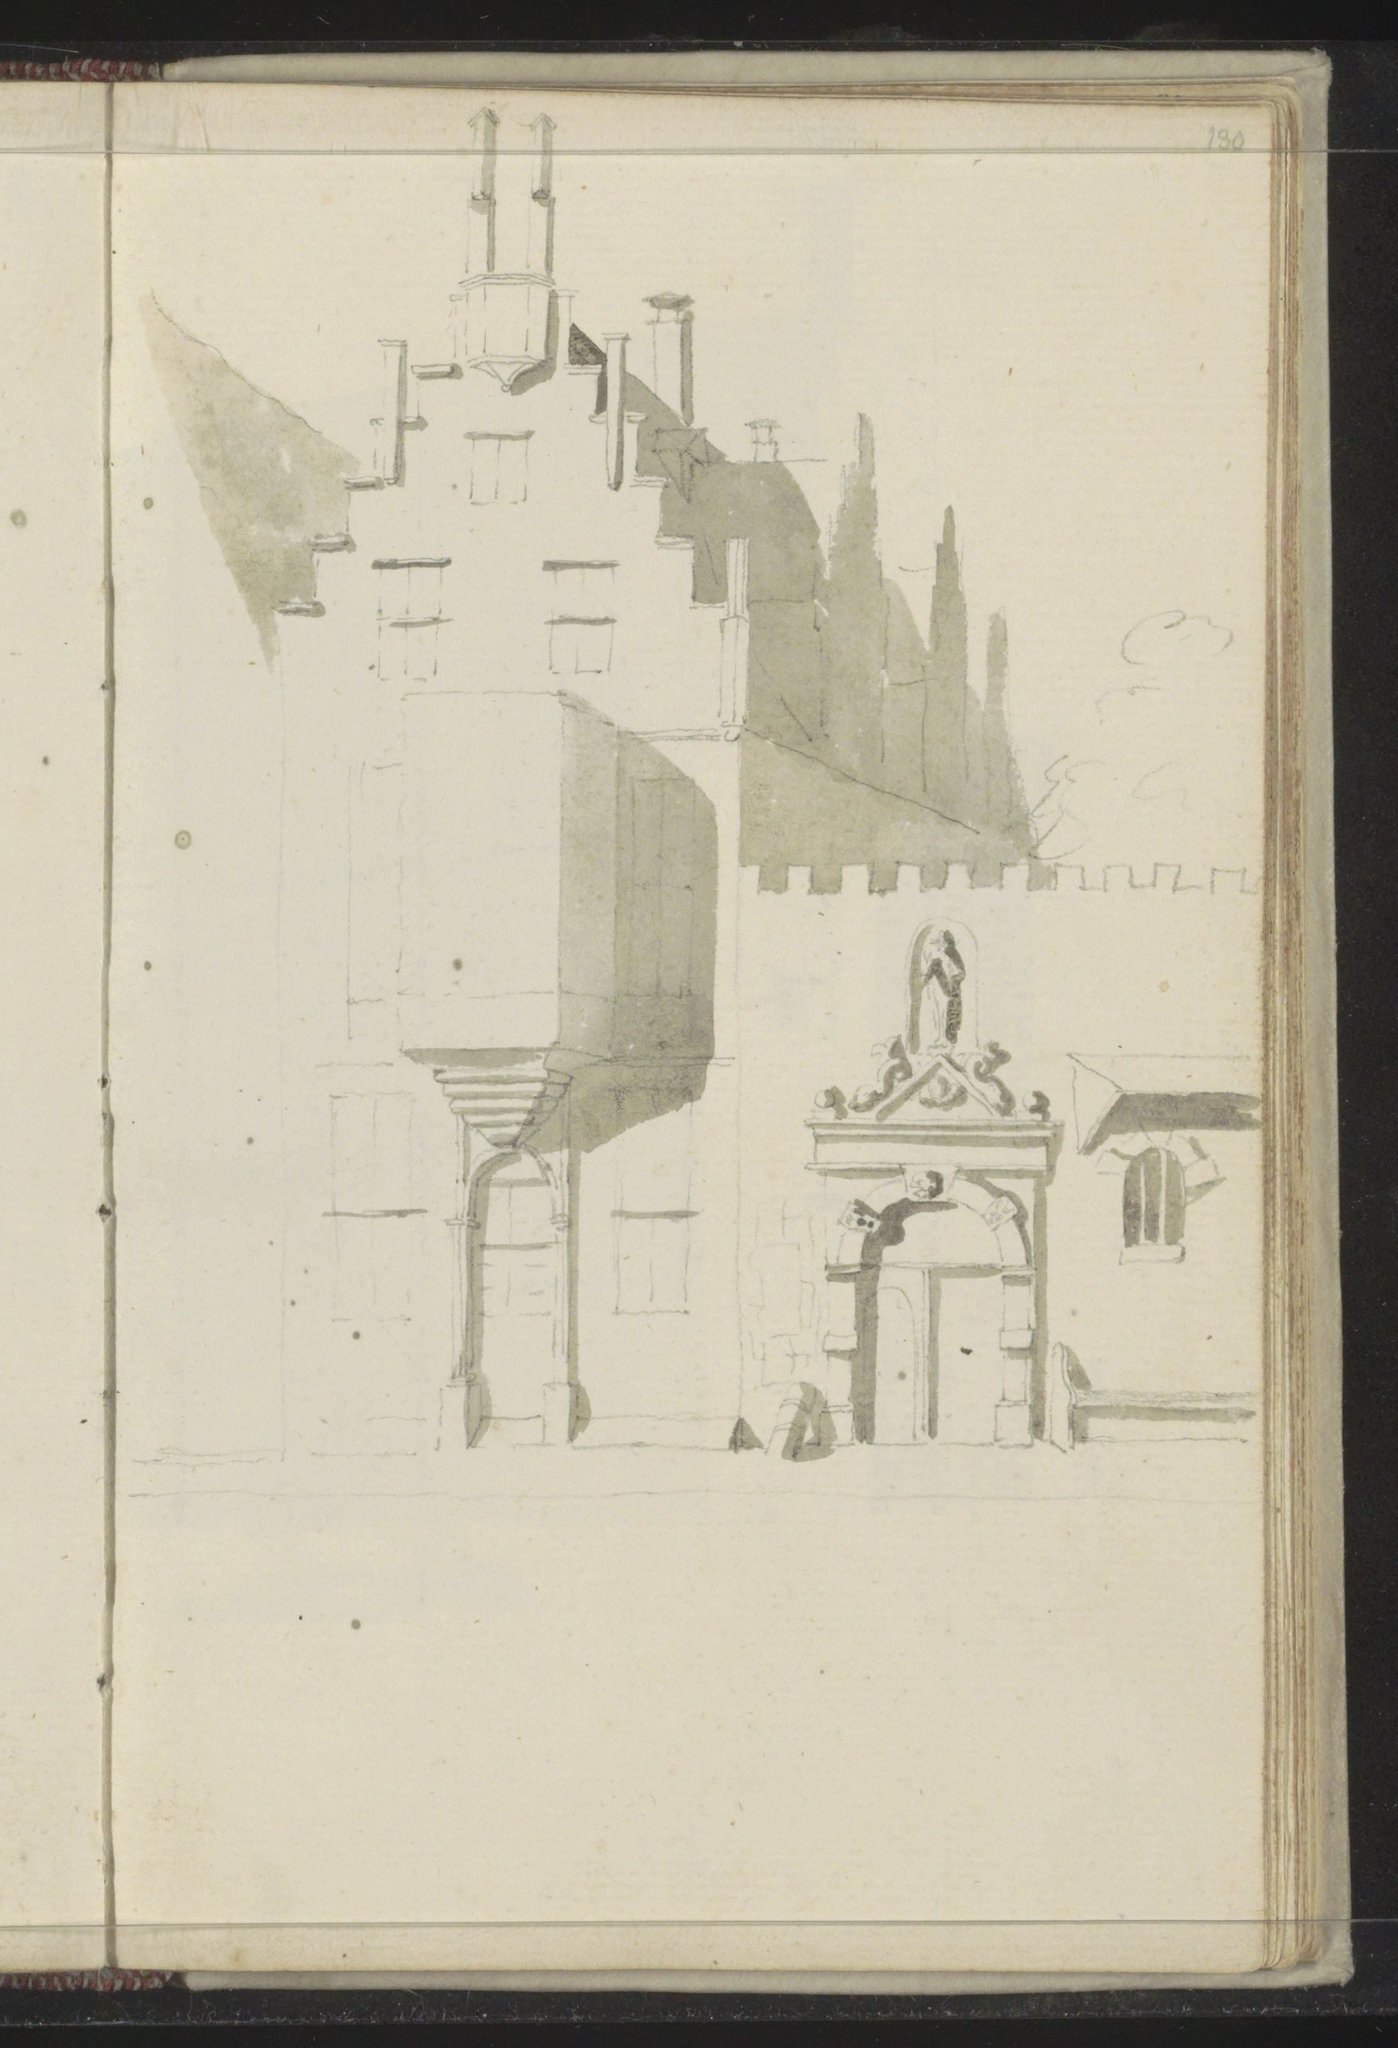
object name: sketchbook leaf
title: Rijtjeshuis met een trapgevel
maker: johannes huibert prins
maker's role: draughtsman, painter, print maker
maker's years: 1757-1806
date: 1783-1797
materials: paper, pencil, watercolor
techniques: brush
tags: decorated gable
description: Pagina 130 uit een schetsboek met 175 pagina's.